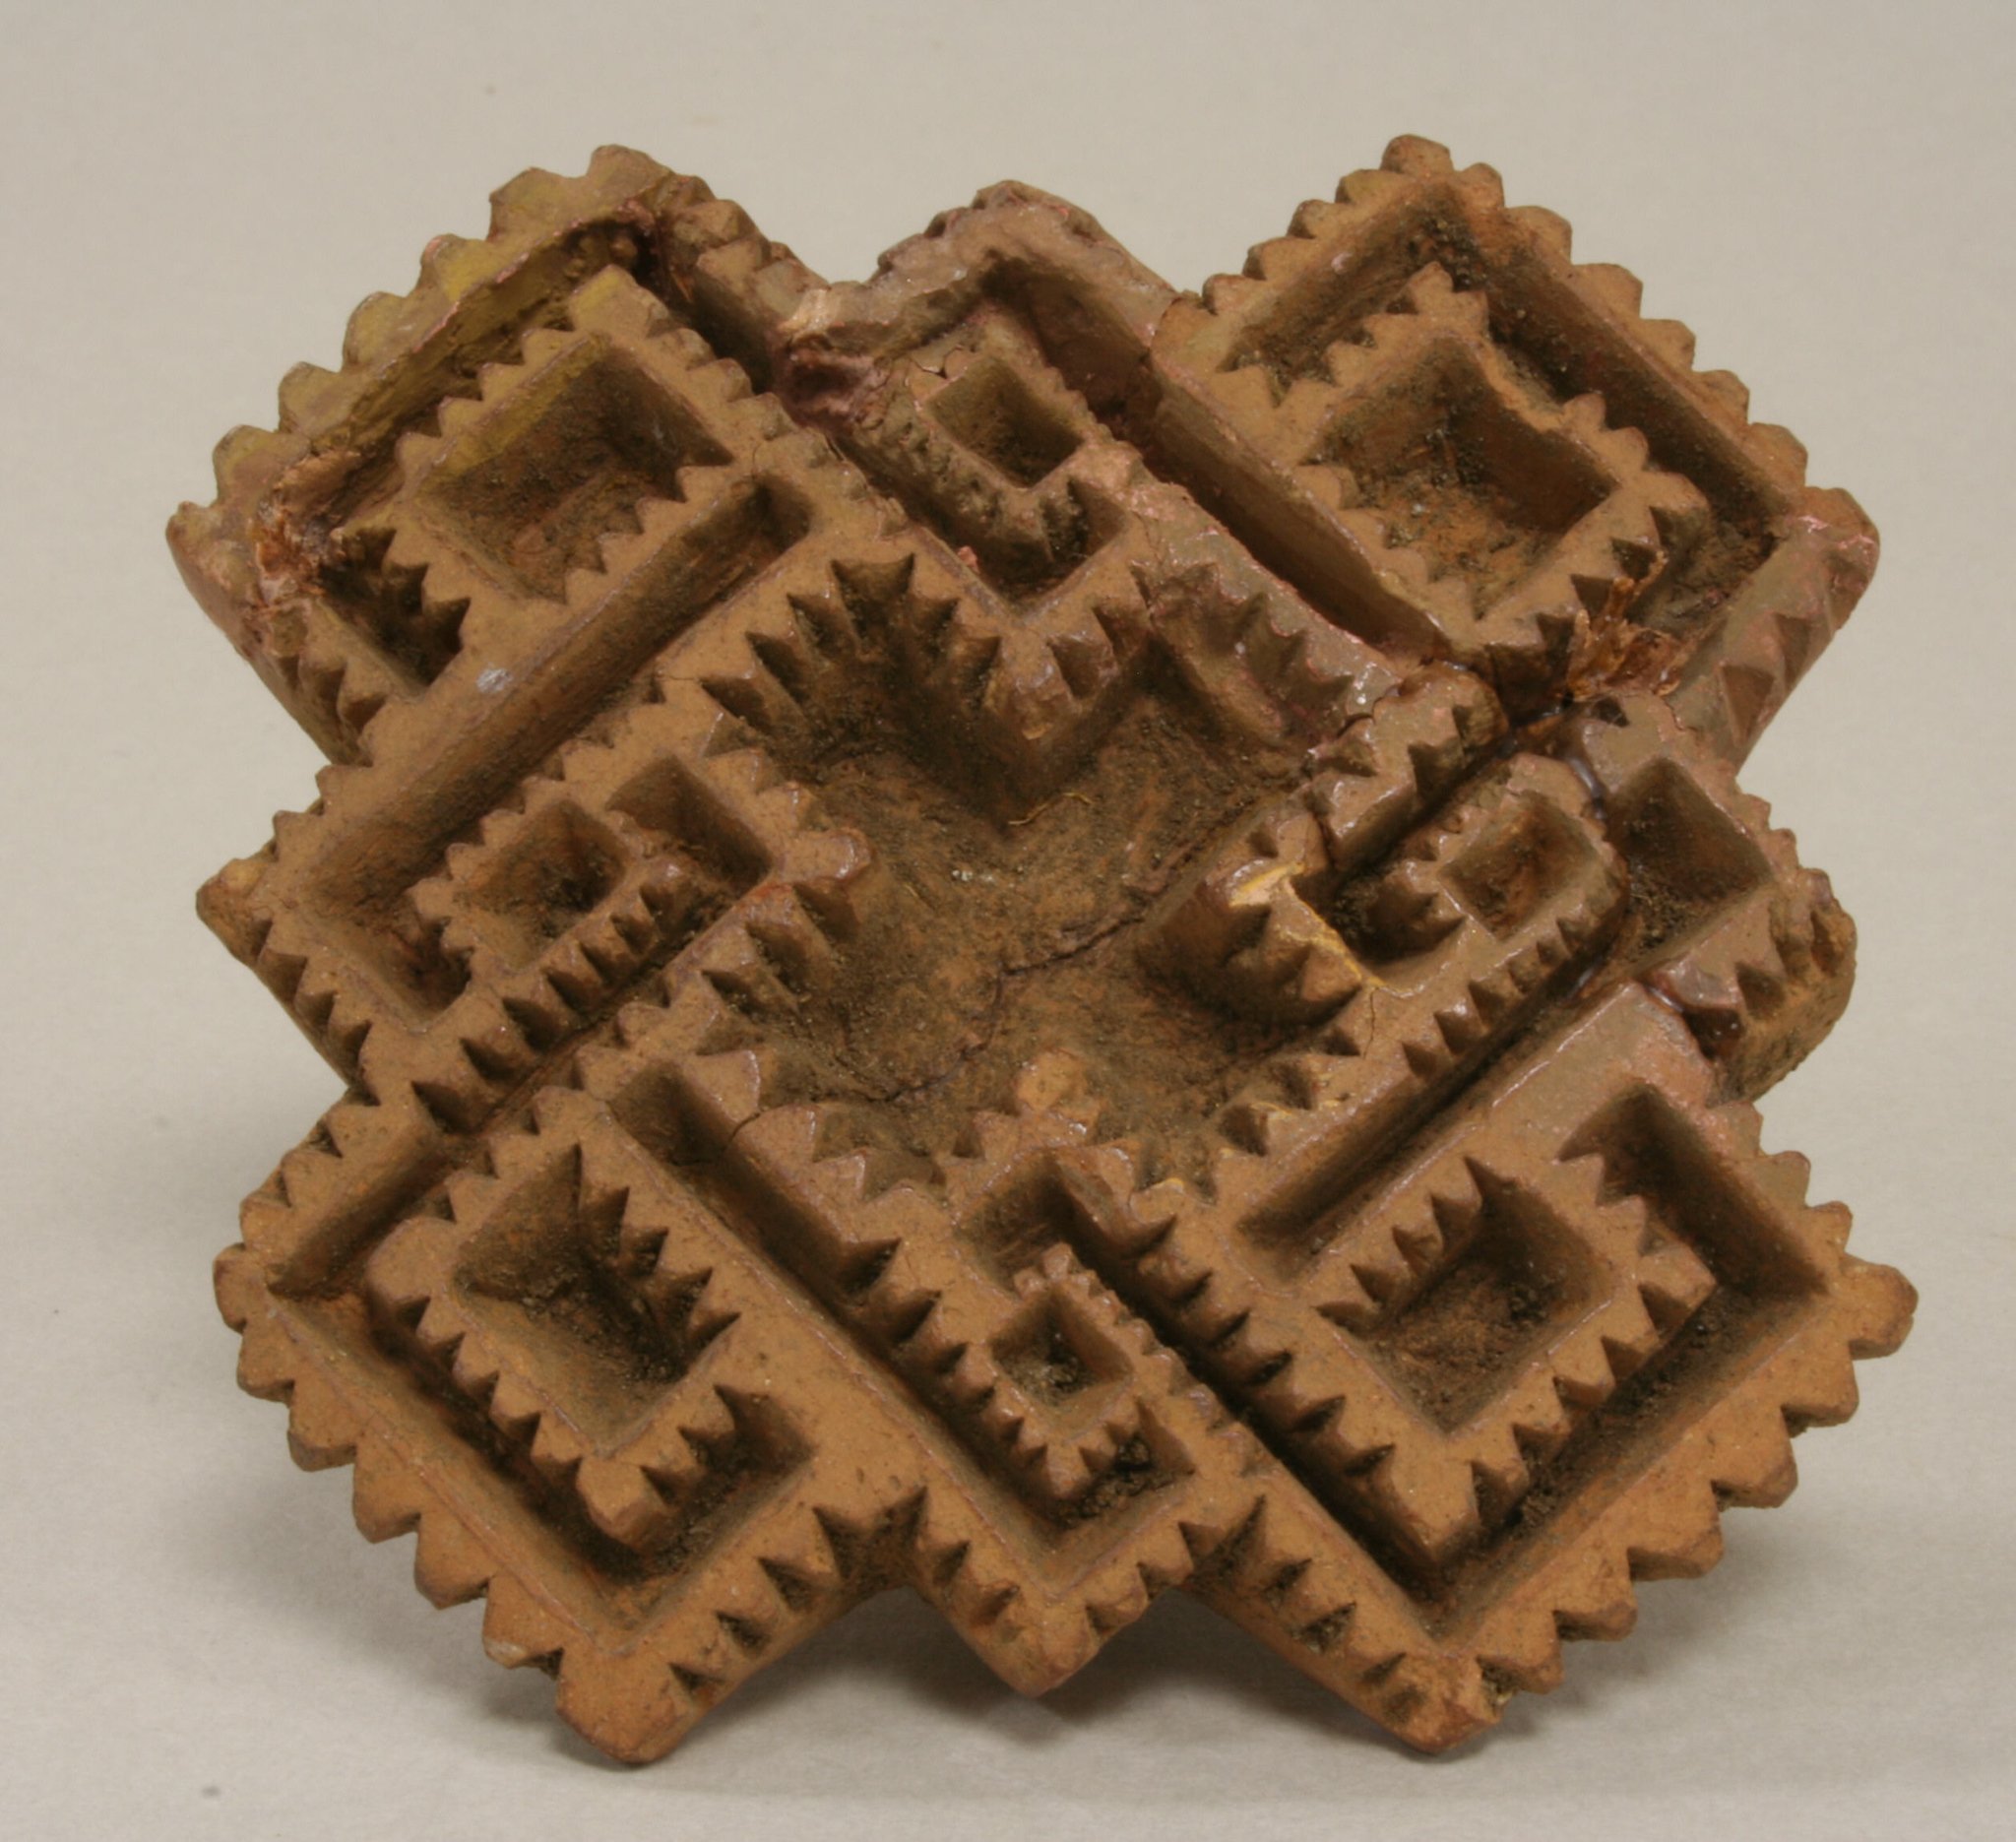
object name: stamp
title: Flat Stamp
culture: atlantic watershed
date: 401-600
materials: ceramic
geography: costa rica